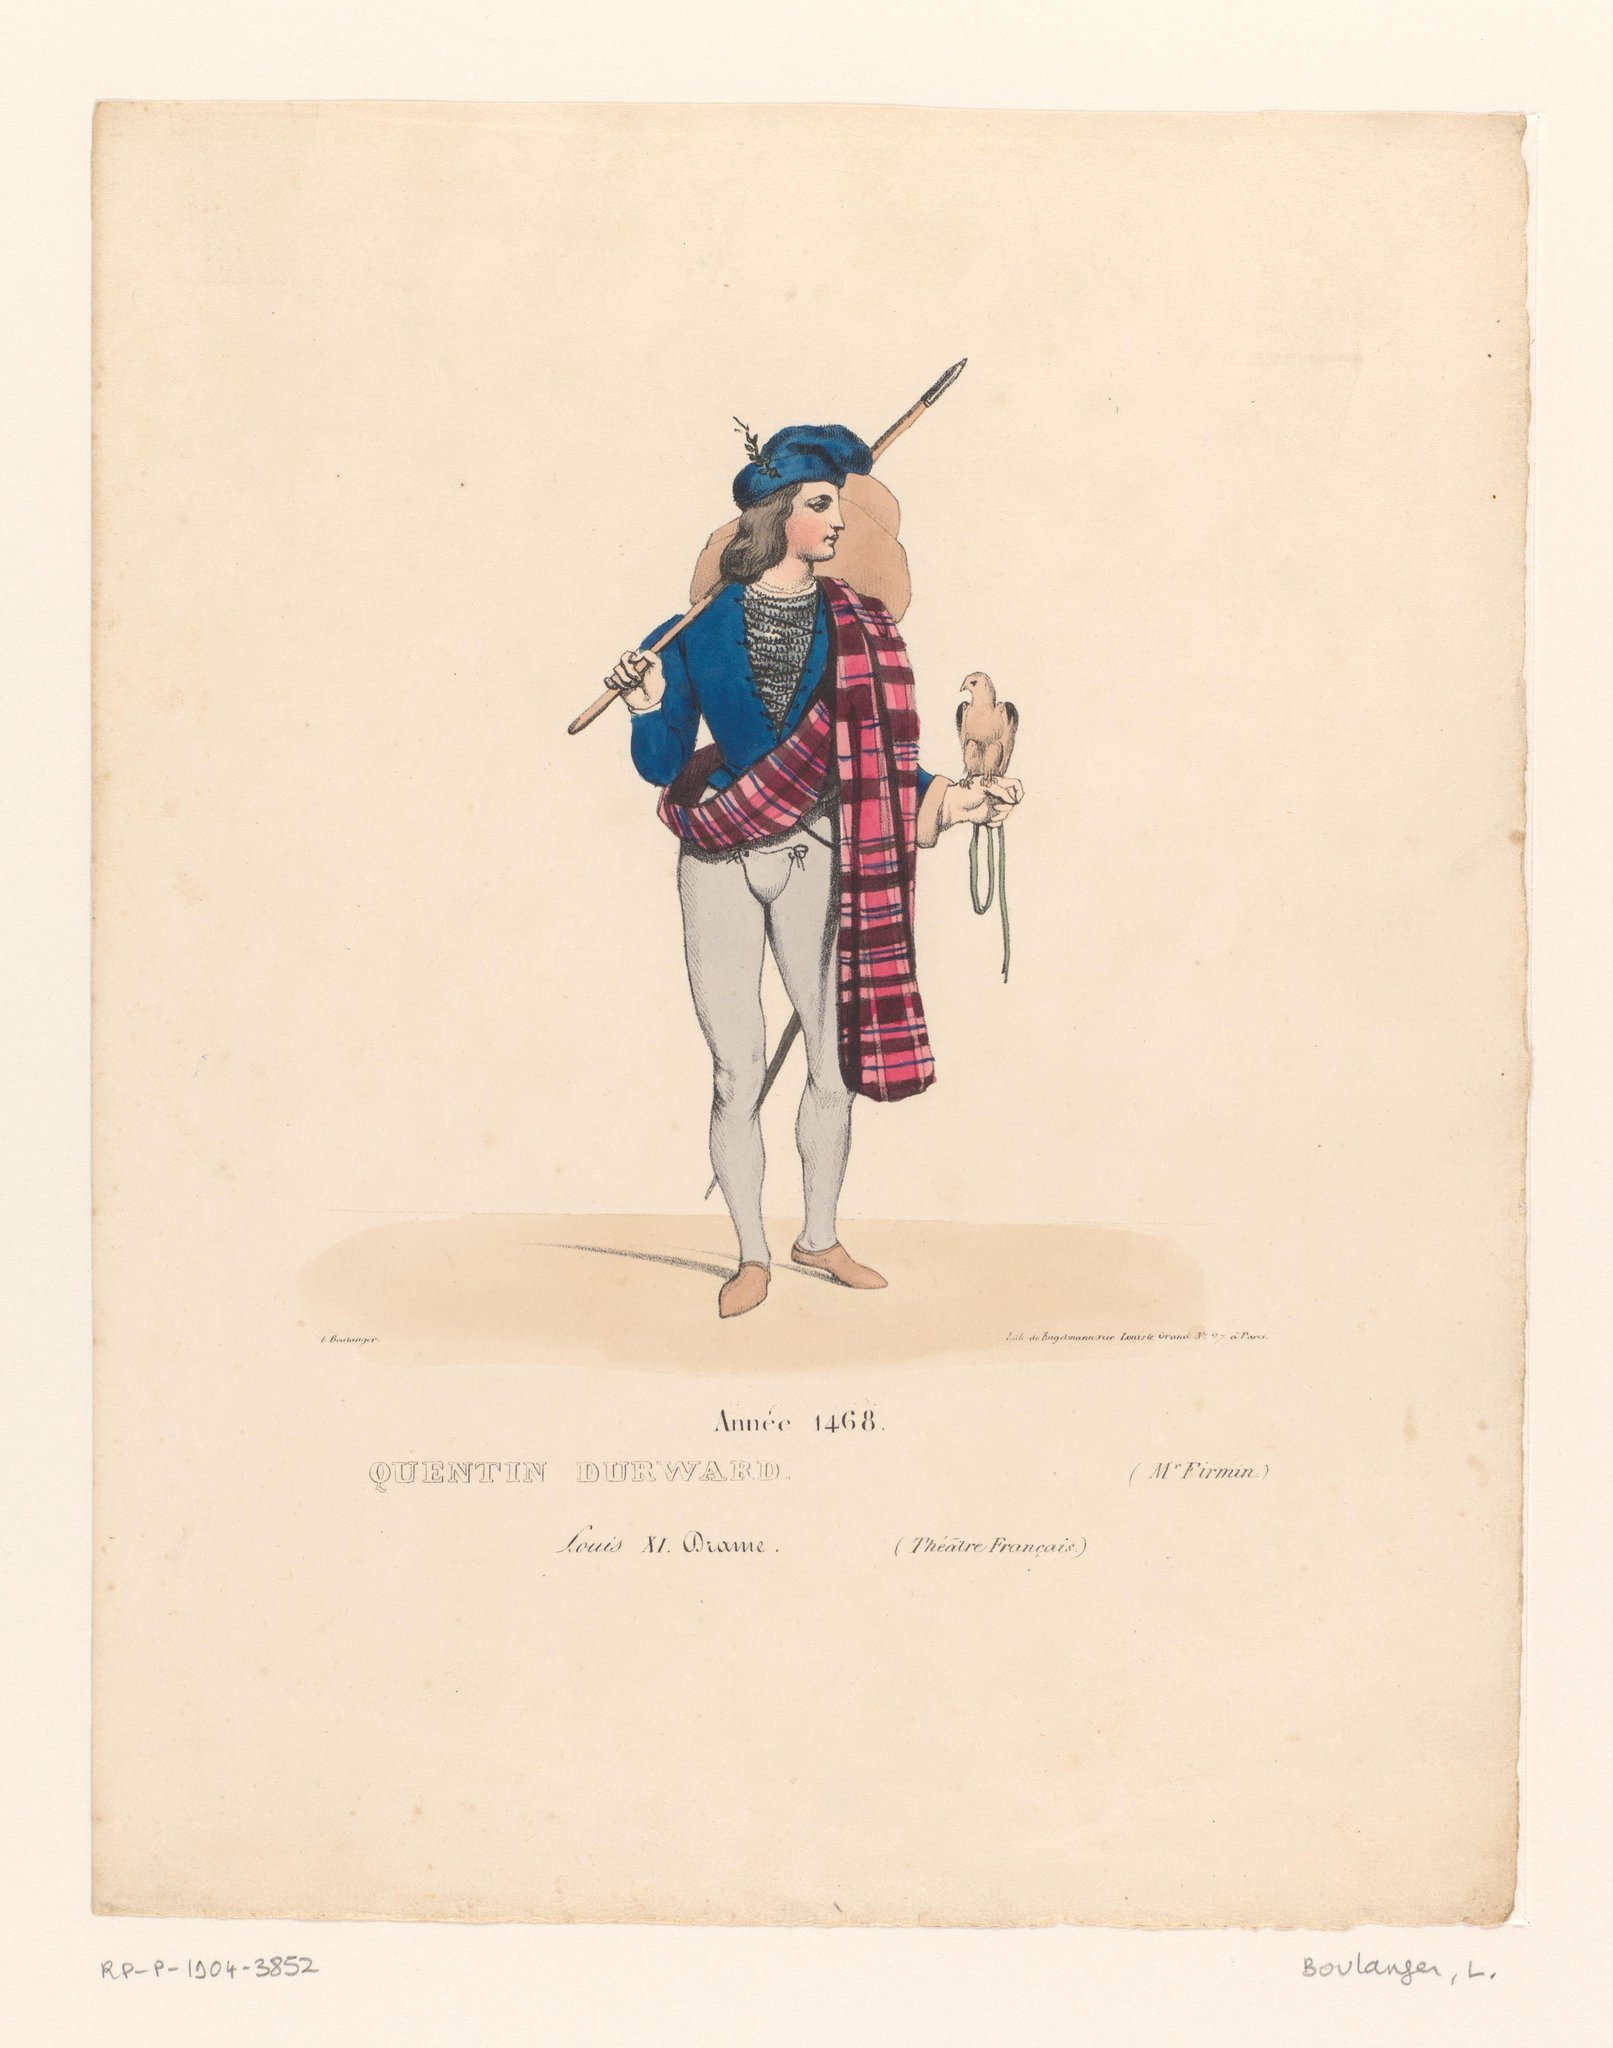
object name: print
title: Theaterkostuums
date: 1826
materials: paper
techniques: hand coloring, lithograph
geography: paris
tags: stage costume, actor (on the stage), tragedy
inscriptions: collector's mark: Lugt 2228a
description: Quentin Durward is de hoofdpersoon uit de gelijknamige roman van Sir Walter Scott. Het toneelstuk 'Louis XI à Péronne' is op dit boek gebaseerd.